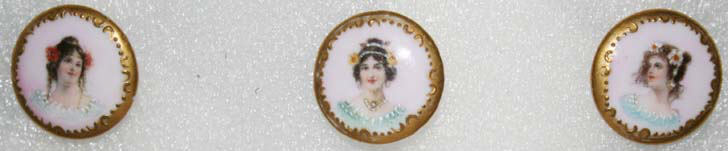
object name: button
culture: european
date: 1801-1900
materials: porcelain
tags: portraits,women